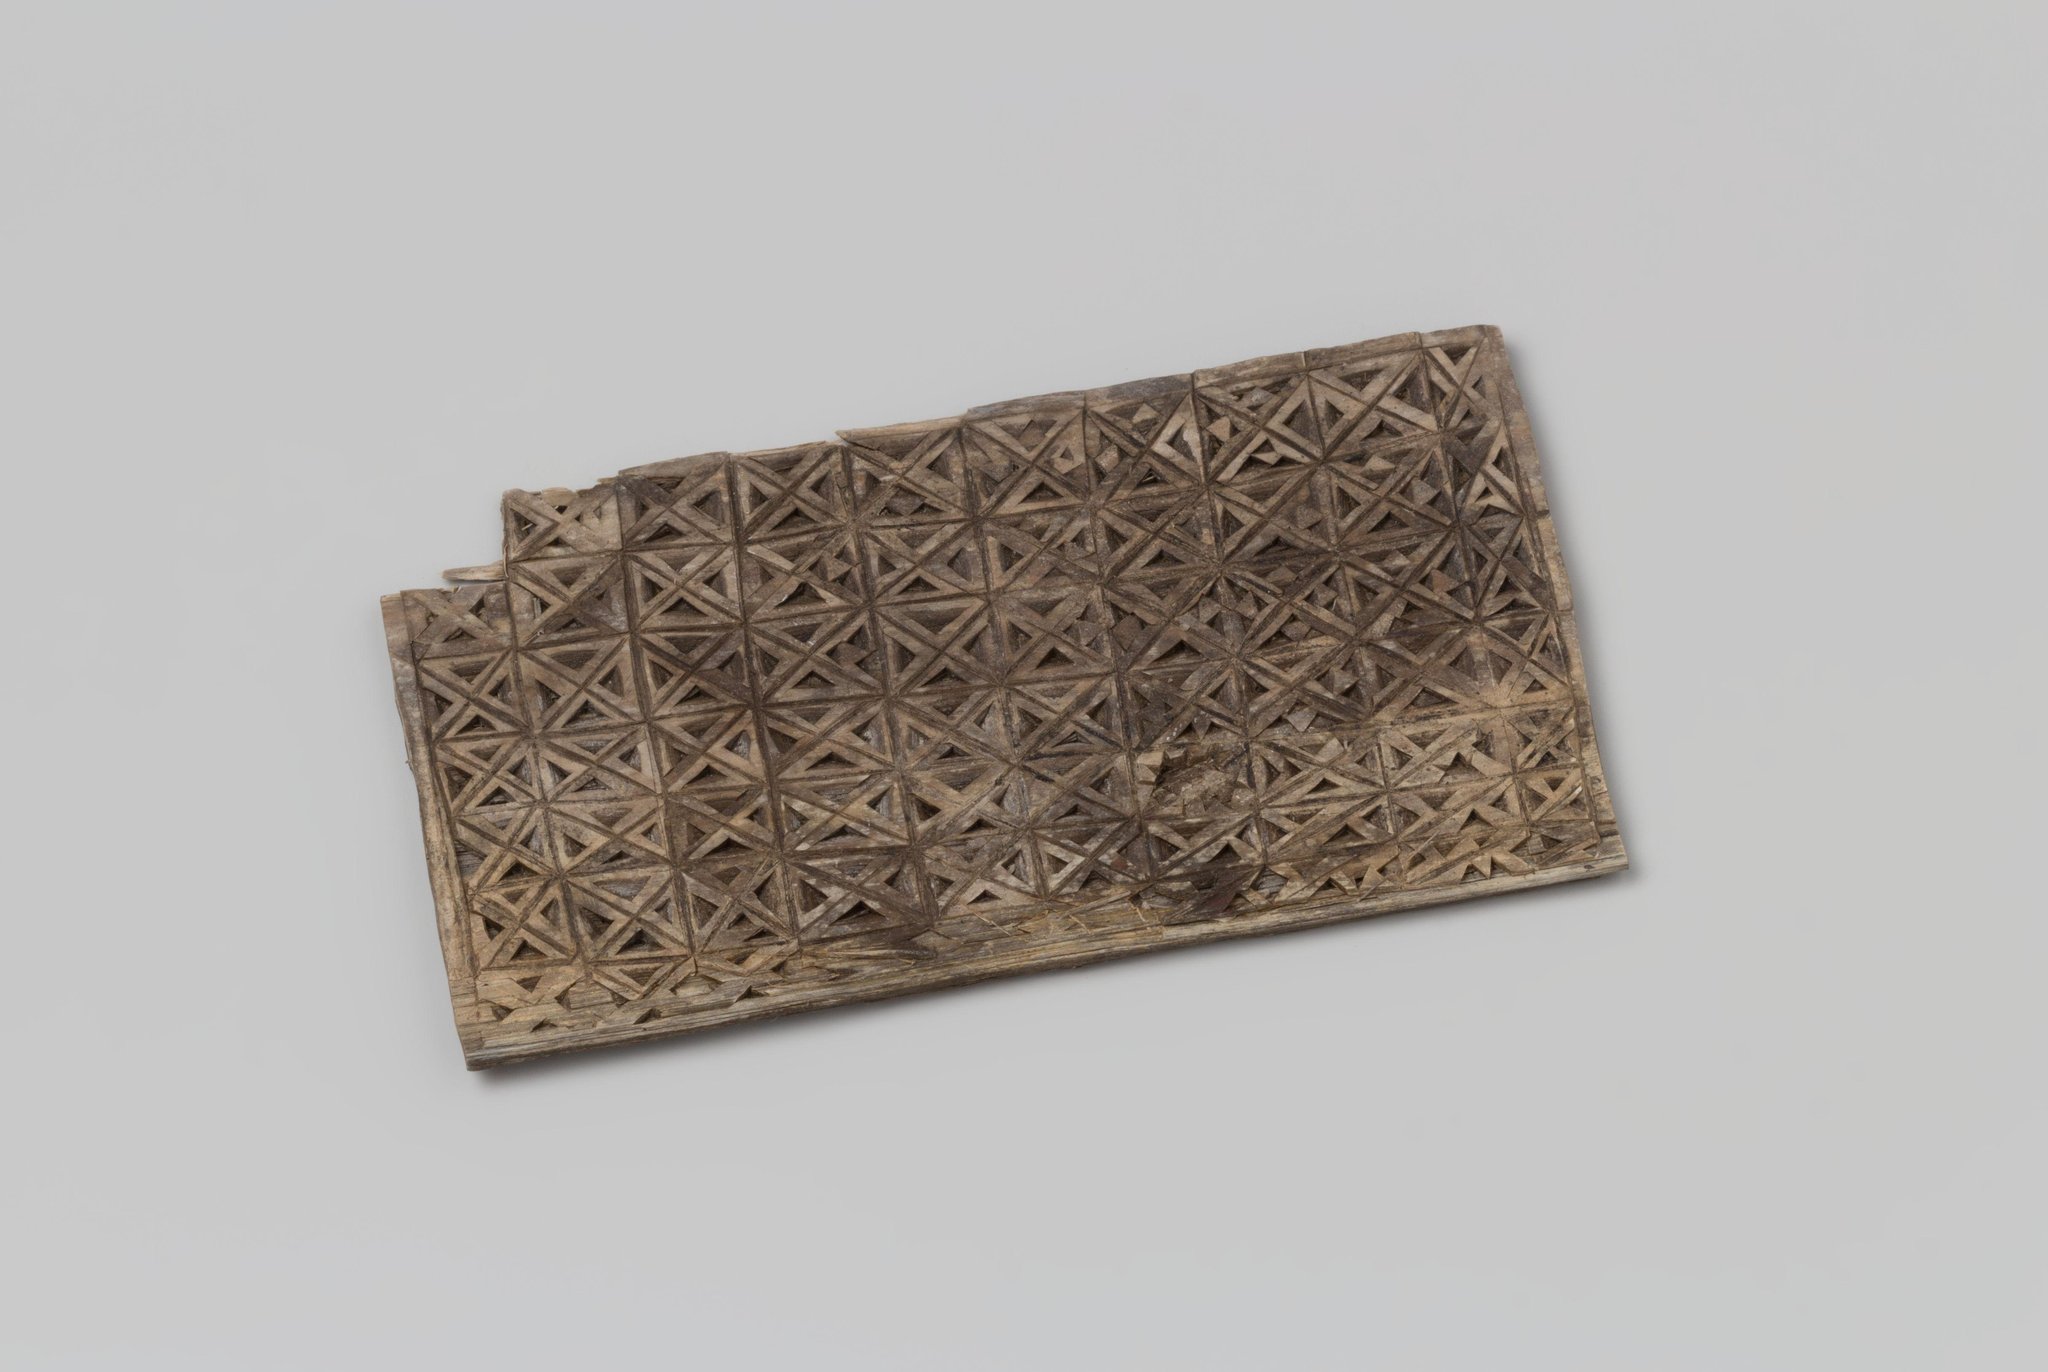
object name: reception piece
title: Proefstuk met balein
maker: Anonymous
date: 1400-1950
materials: baleen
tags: zeeuwsche uytkyck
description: Proefstuk met balein; met ingekrast kruismotief.